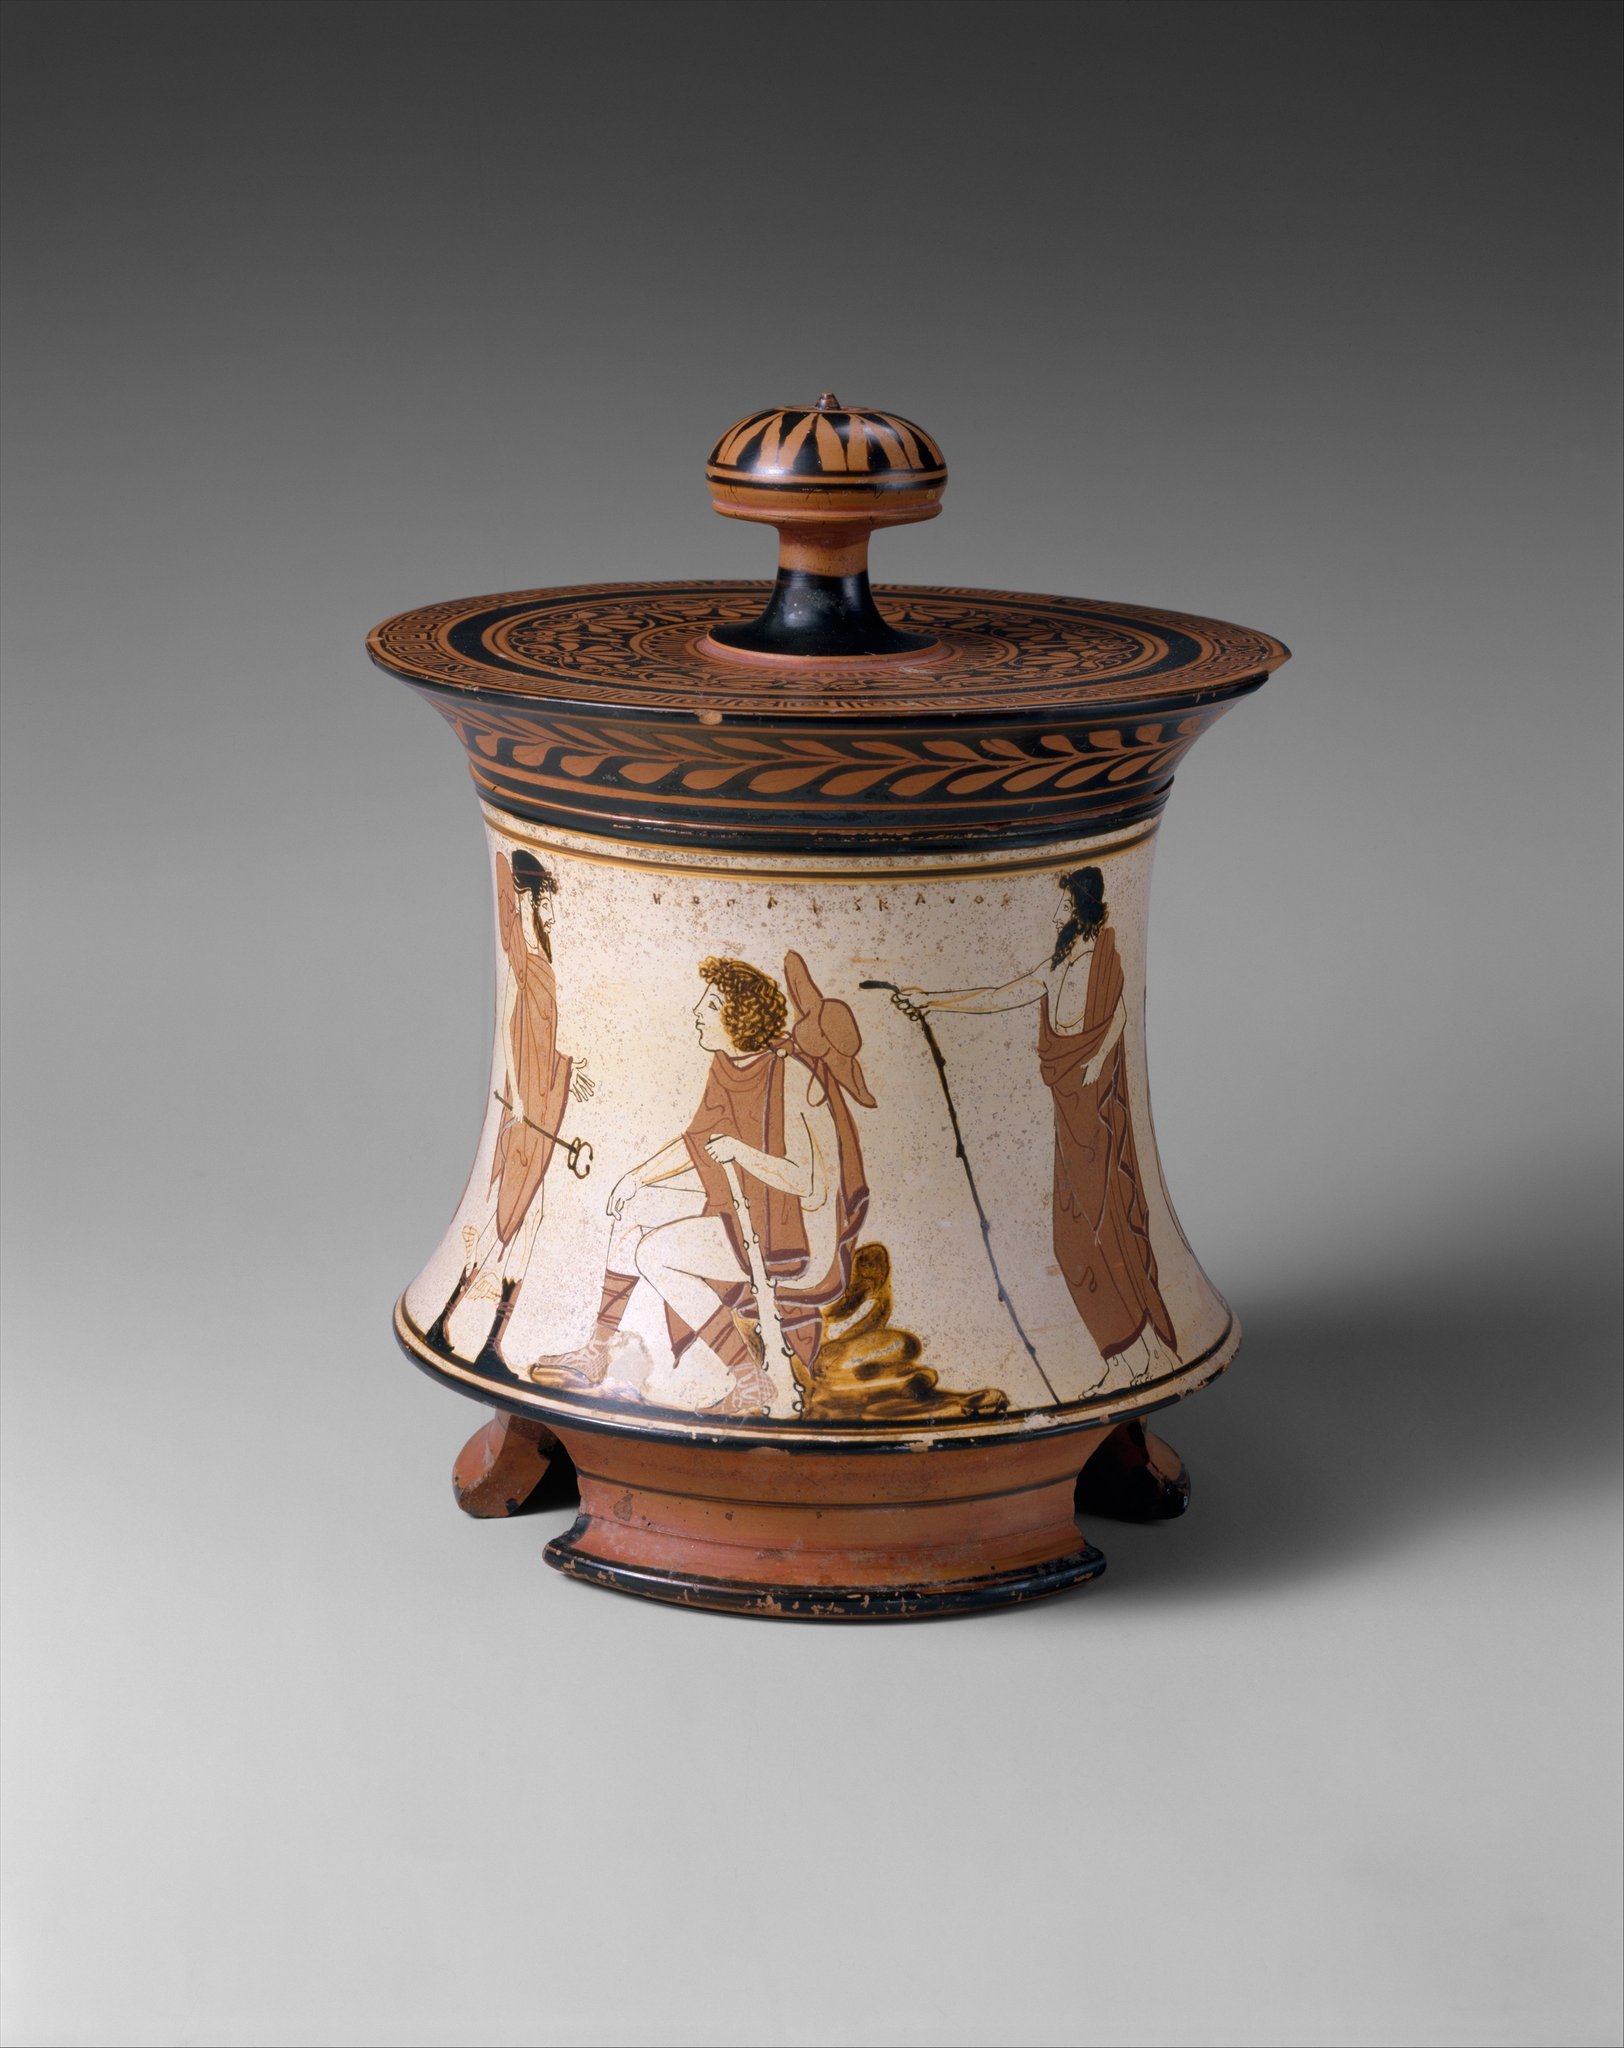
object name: pyxis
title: Terracotta pyxis (box)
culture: greek, attic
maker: penthesilea painter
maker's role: artist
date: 465-460 BCE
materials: terracotta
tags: men,women